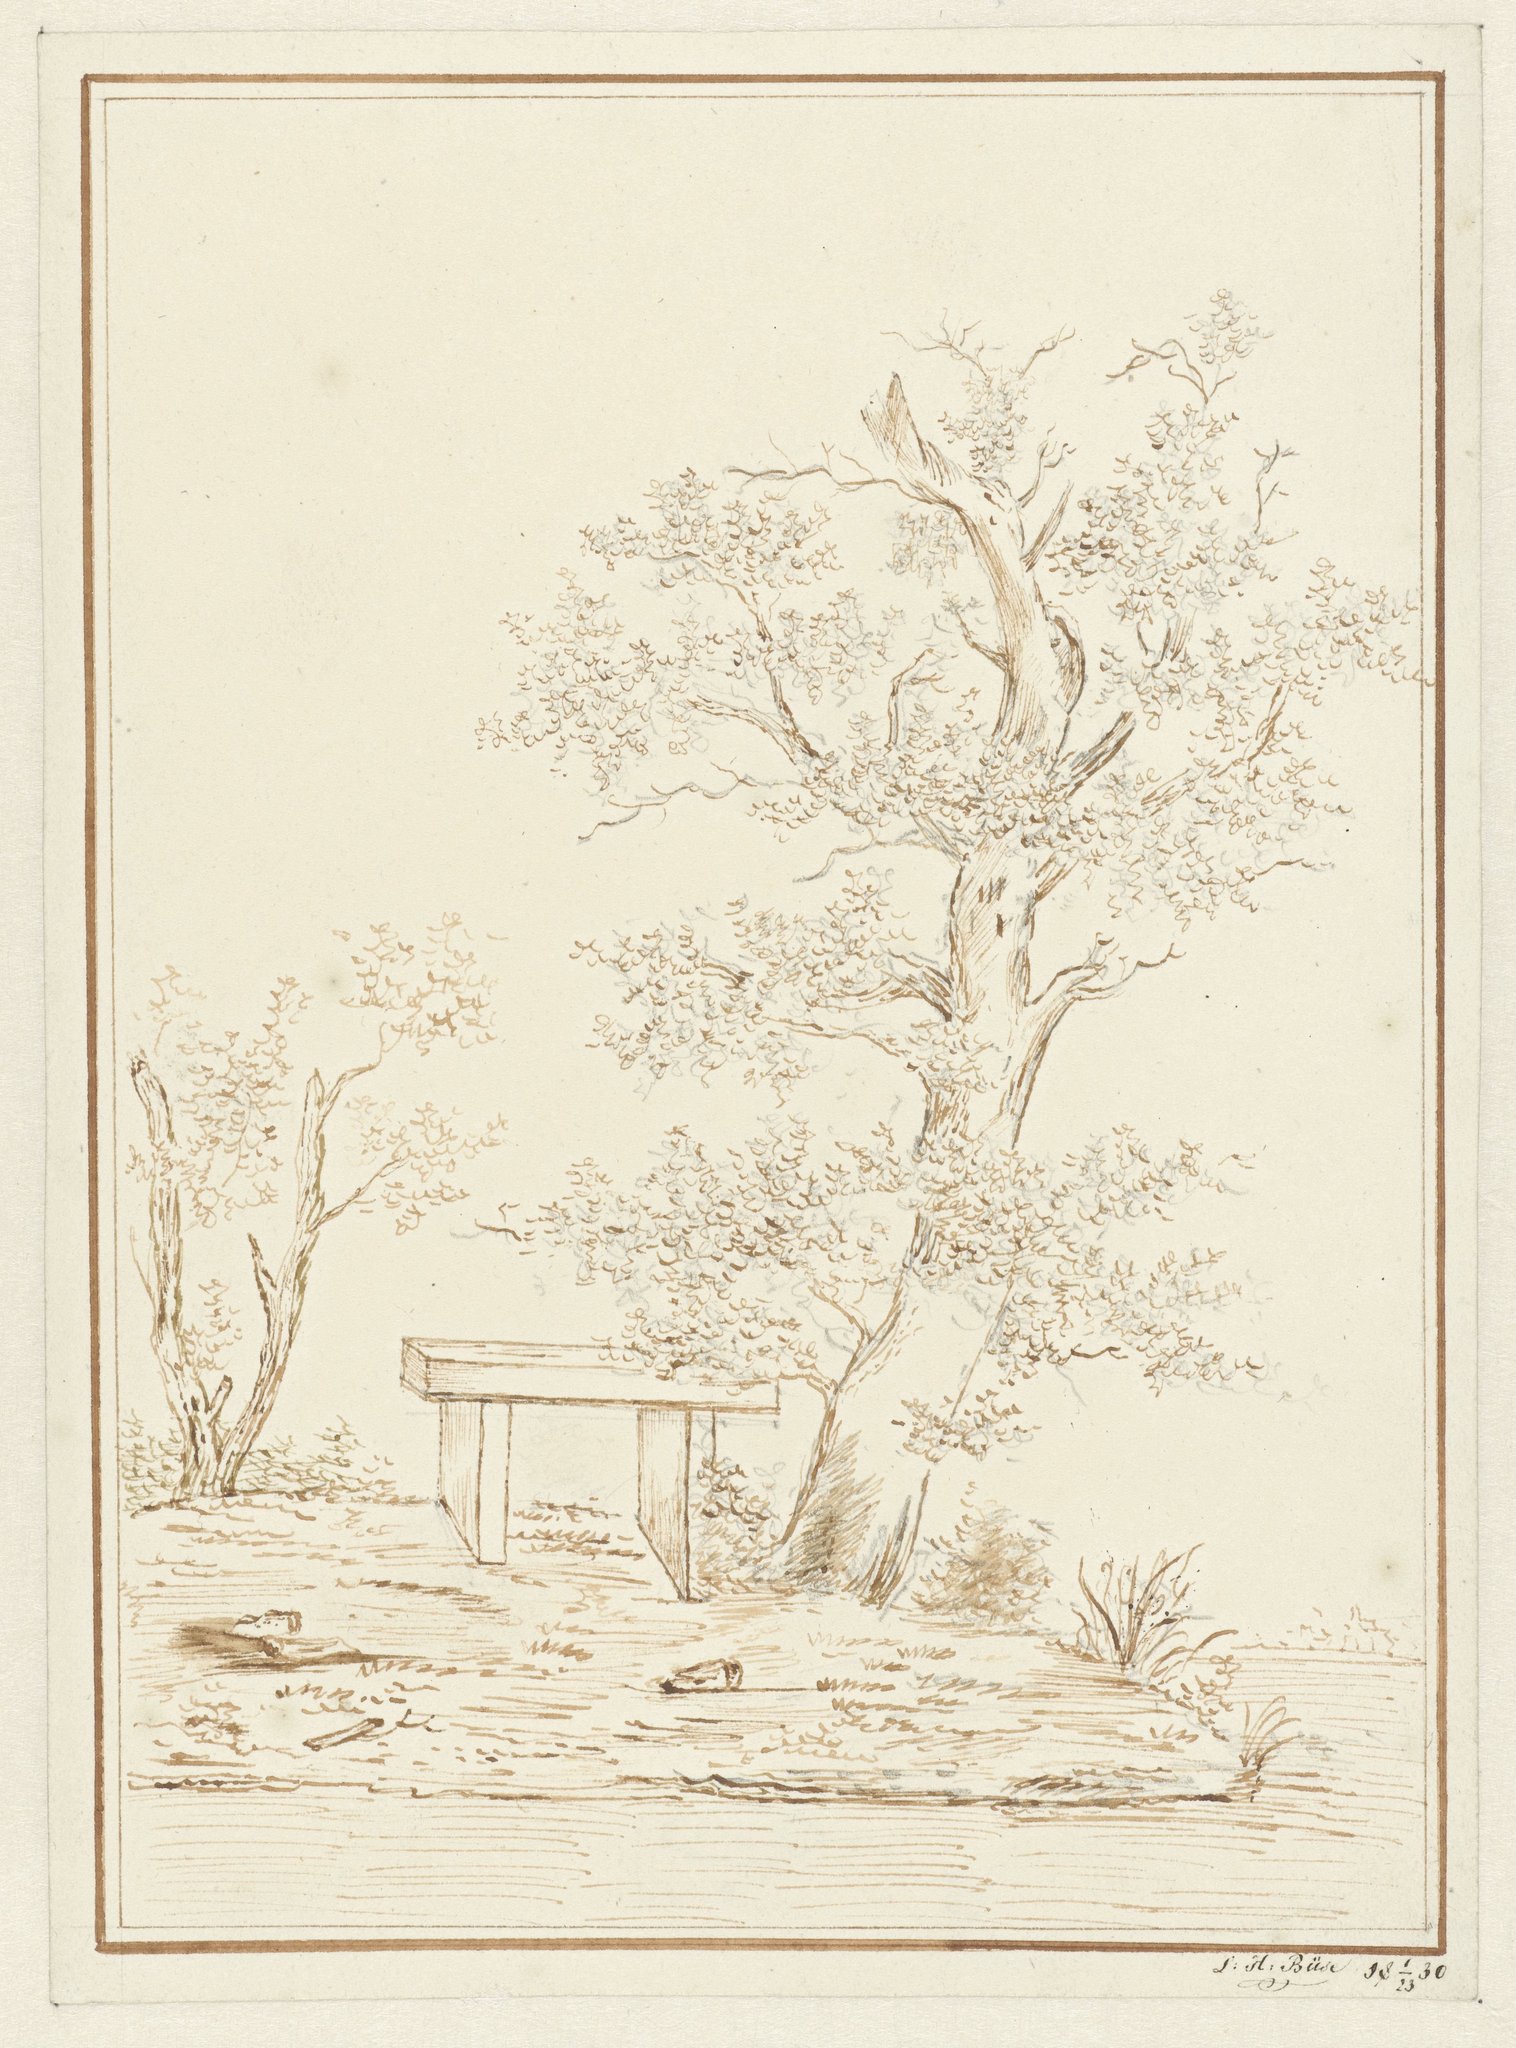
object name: drawing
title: Rivierlandschap met bank aan de oever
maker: l.h. büse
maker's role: draughtsman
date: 1830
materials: ink, paper, pencil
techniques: pen